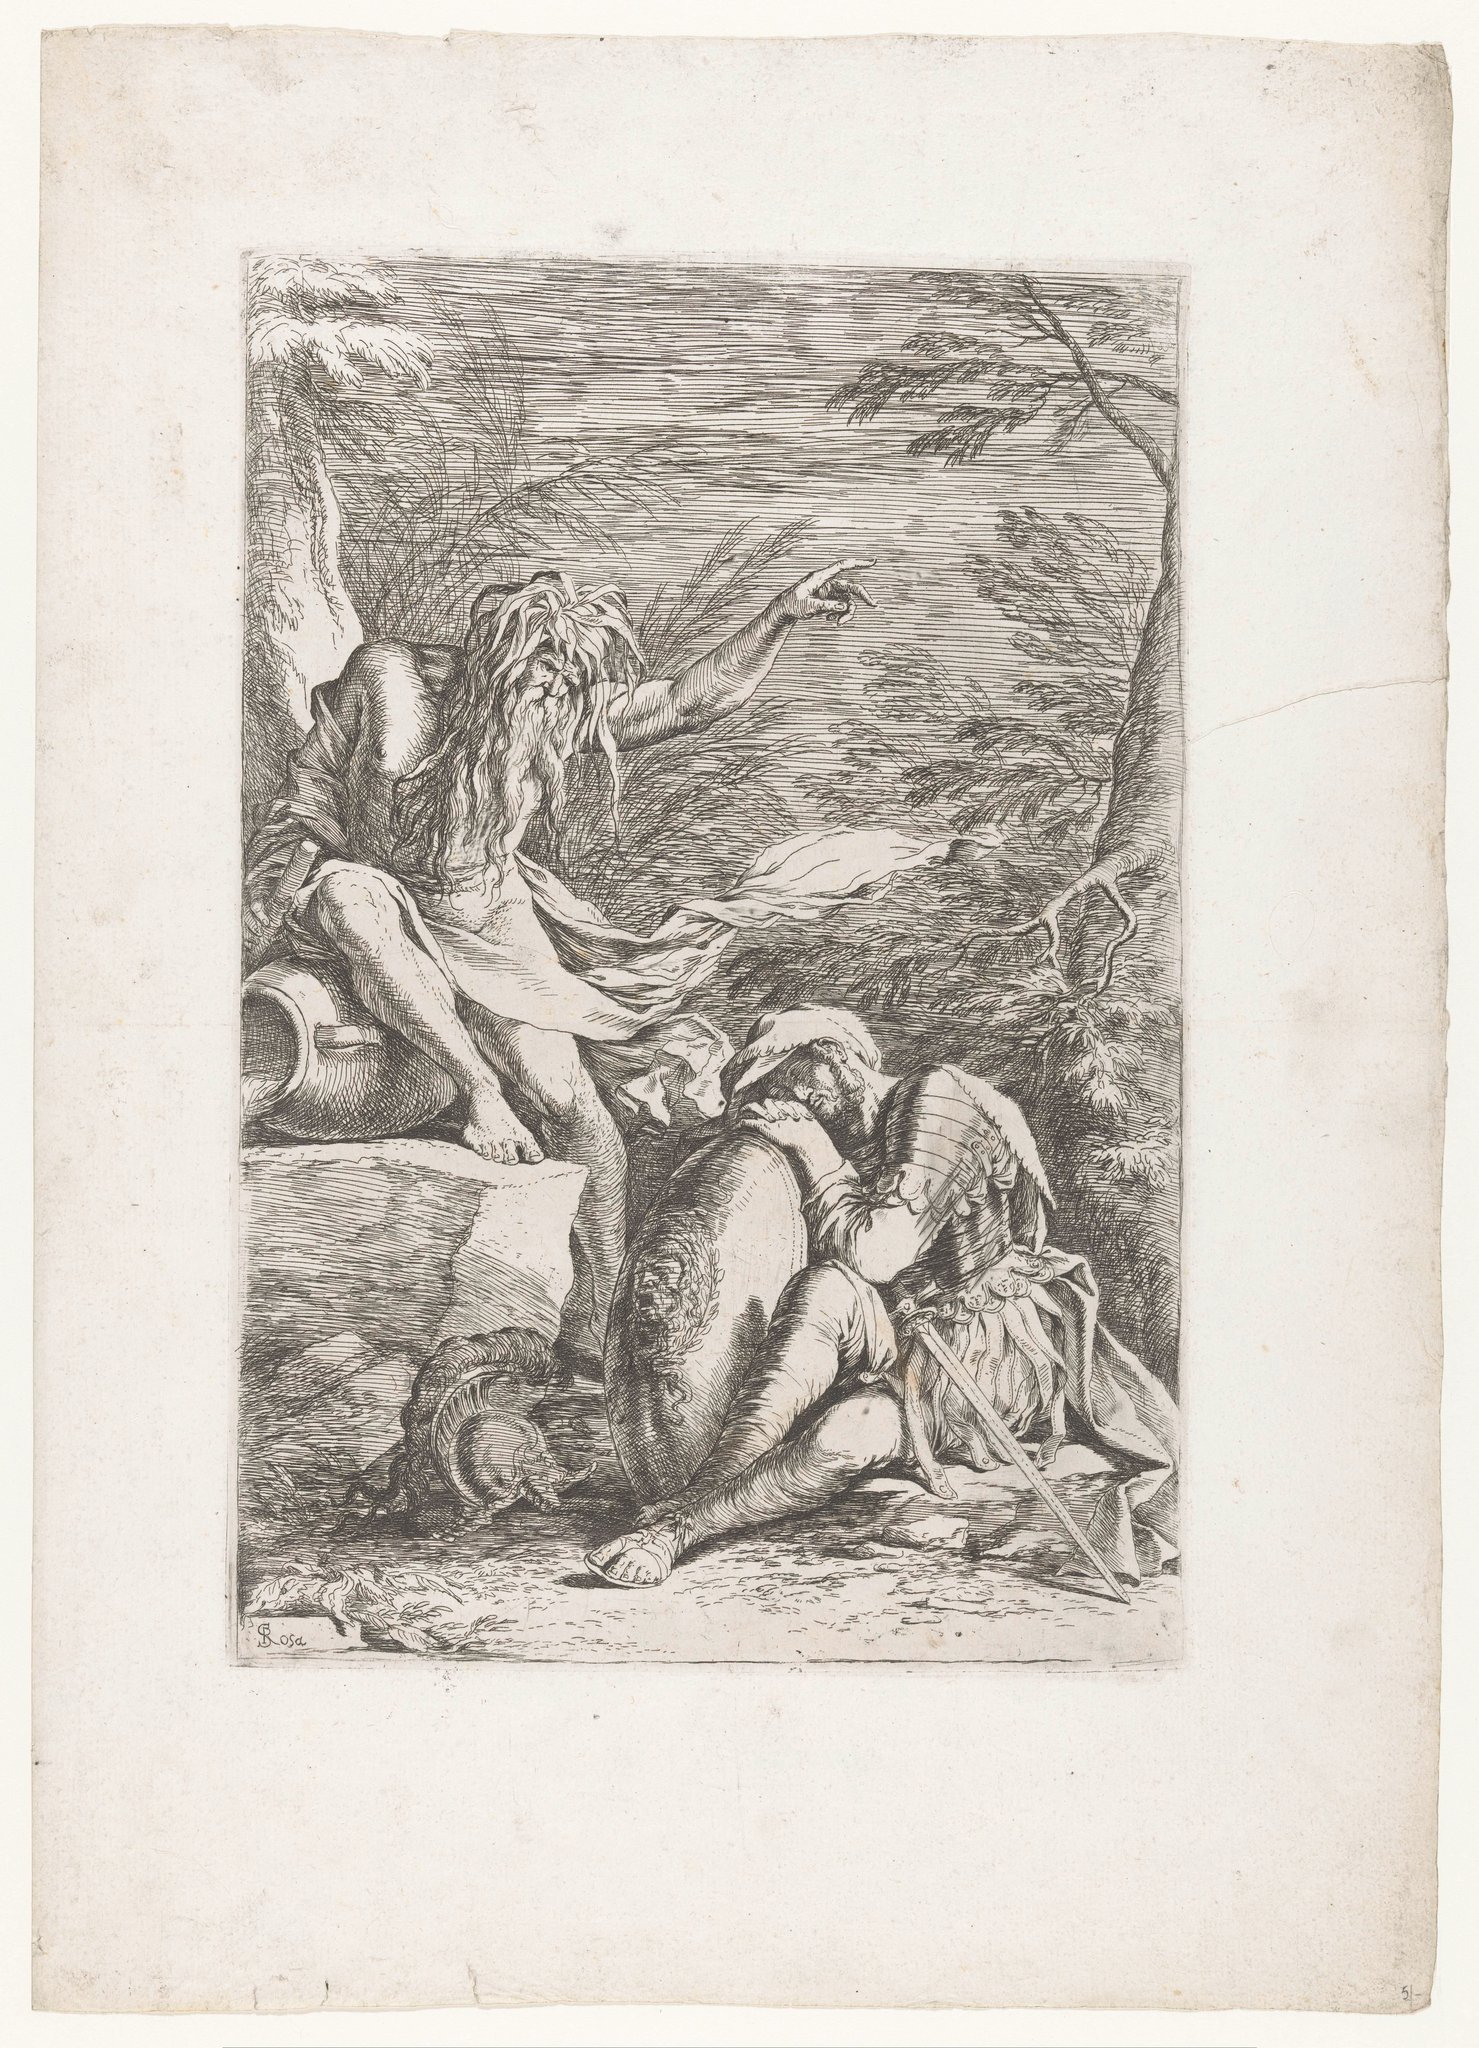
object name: print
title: Tiberinus verschijnt aan Aeneas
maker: salvator rosa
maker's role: draughtsman, painter, print maker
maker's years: 1615-1673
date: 1663-1664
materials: paper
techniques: drypoint, etching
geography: italy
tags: the river-god tiberinus appears to aeneas in his sleep, plants and herbs: reed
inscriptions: collector's mark: ‘RIJKS / MUSM’, collector's mark: Lugt 2760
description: Tiberinus, de riviergod van de Romeinse rivier de Tiber, verschijnt aan Aeneas tijdens een droom. De riviergod links met zijn urn, een lange baard en rietstengels op het hoofd. Rechts slaapt Aeneas, leunend op zijn schild.